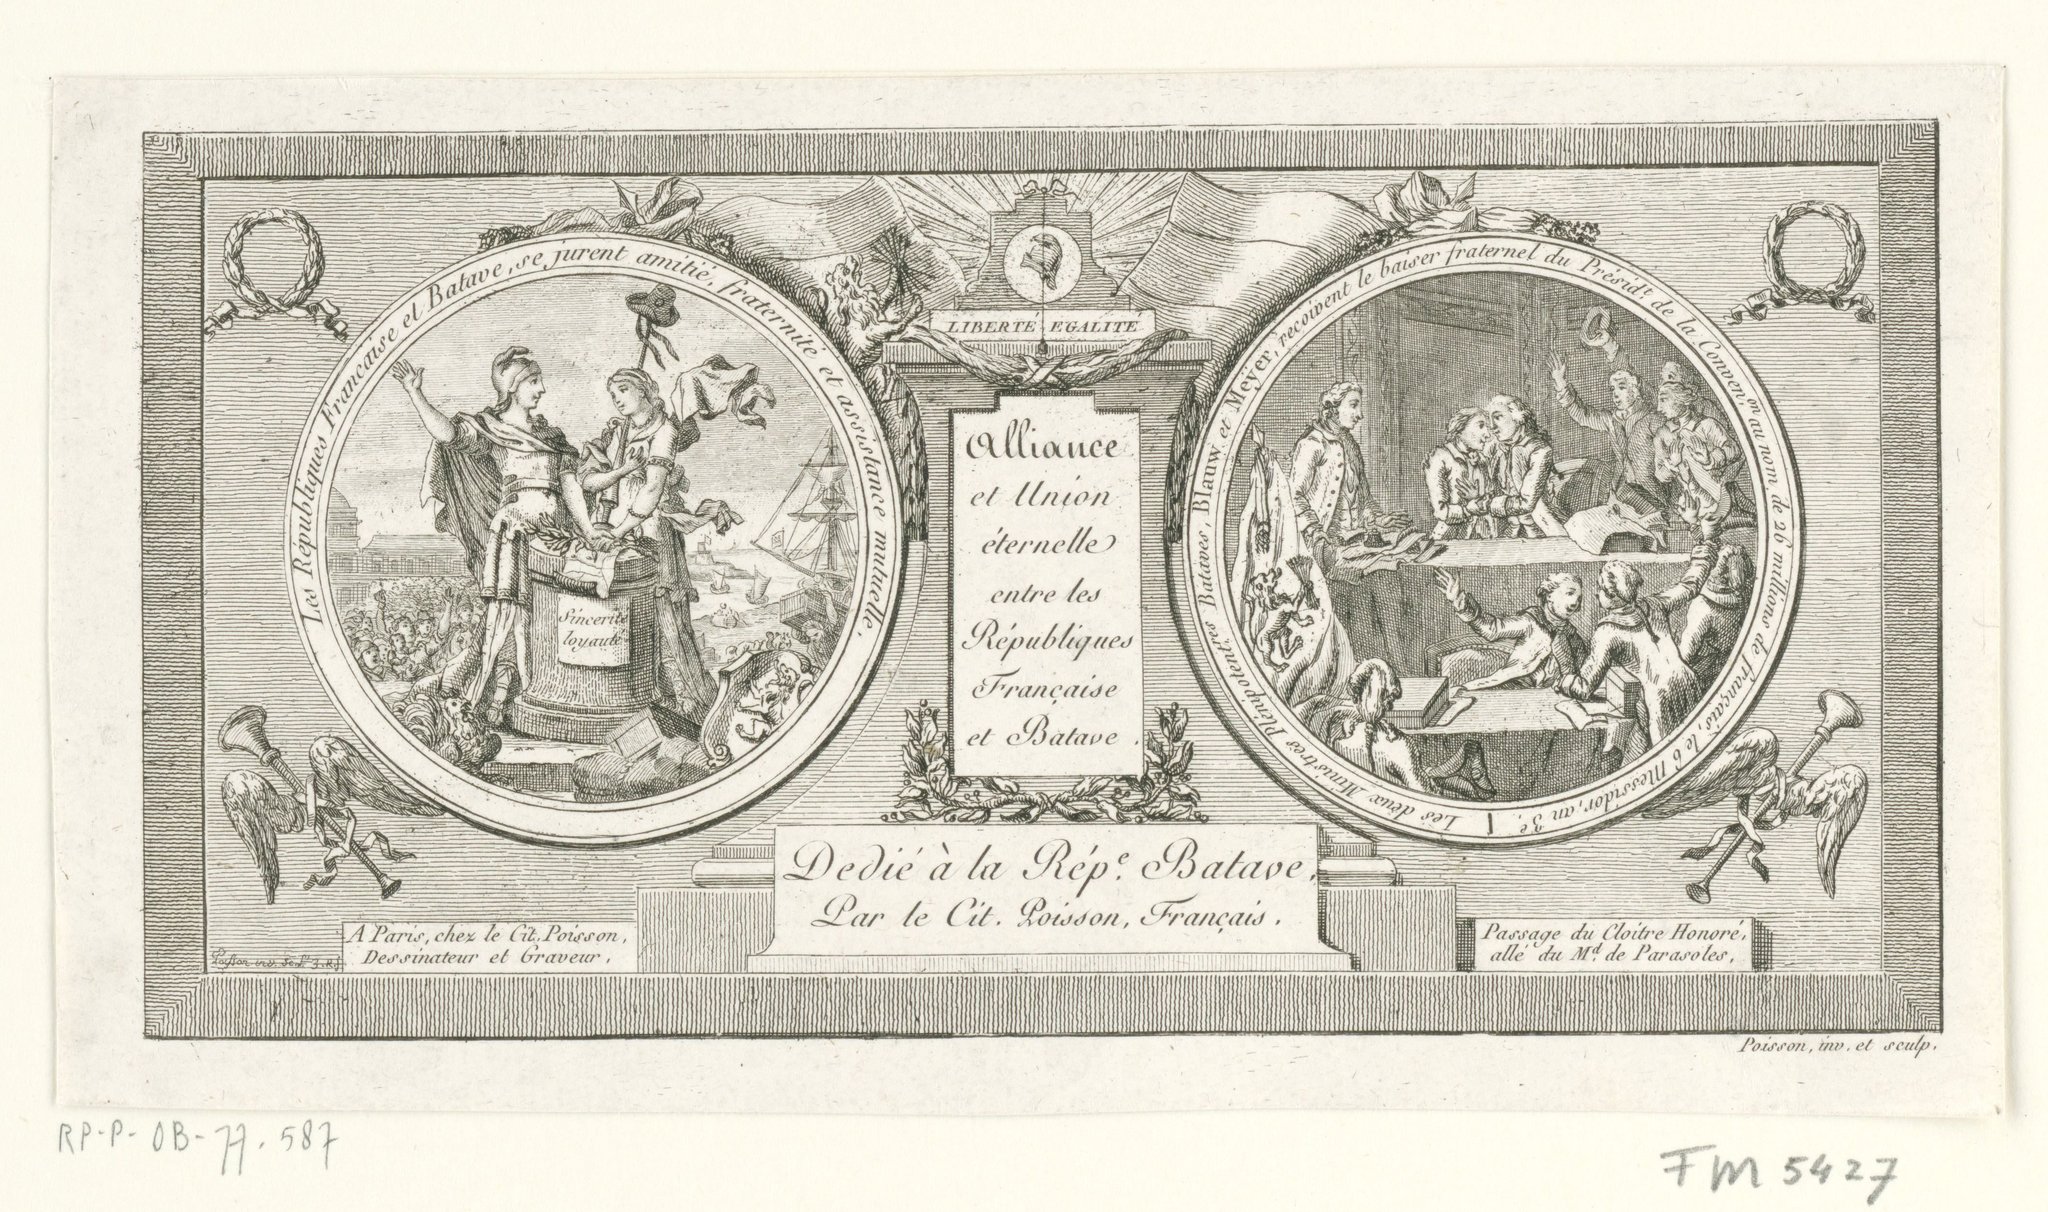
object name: print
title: Medaillon op de Alliantie tussen de Franse en de Bataafse Republieken, 1795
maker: poisson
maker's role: publisher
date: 1795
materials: paper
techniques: engraving, etching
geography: paris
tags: medal (considered as a piece of sculpture, regardless of its specific function), alliance with france (1795)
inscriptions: collector's mark: Lugt 2228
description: Allegorische medaillons op de Alliantie tussen de Franse en de Bataafse Republieken, 1795. Links allegorie op de nieuwe alliantie (Fransman met revolutionaire muts en de Nederlandse maagd met vrijheidshoed op een stok). Rechts het ontvangen van de broederkus door de Hollandse vertegenwoordigers Blauw en Meyer van de voorzitter van de Franse Conventie op 6 Messidor, An 3.